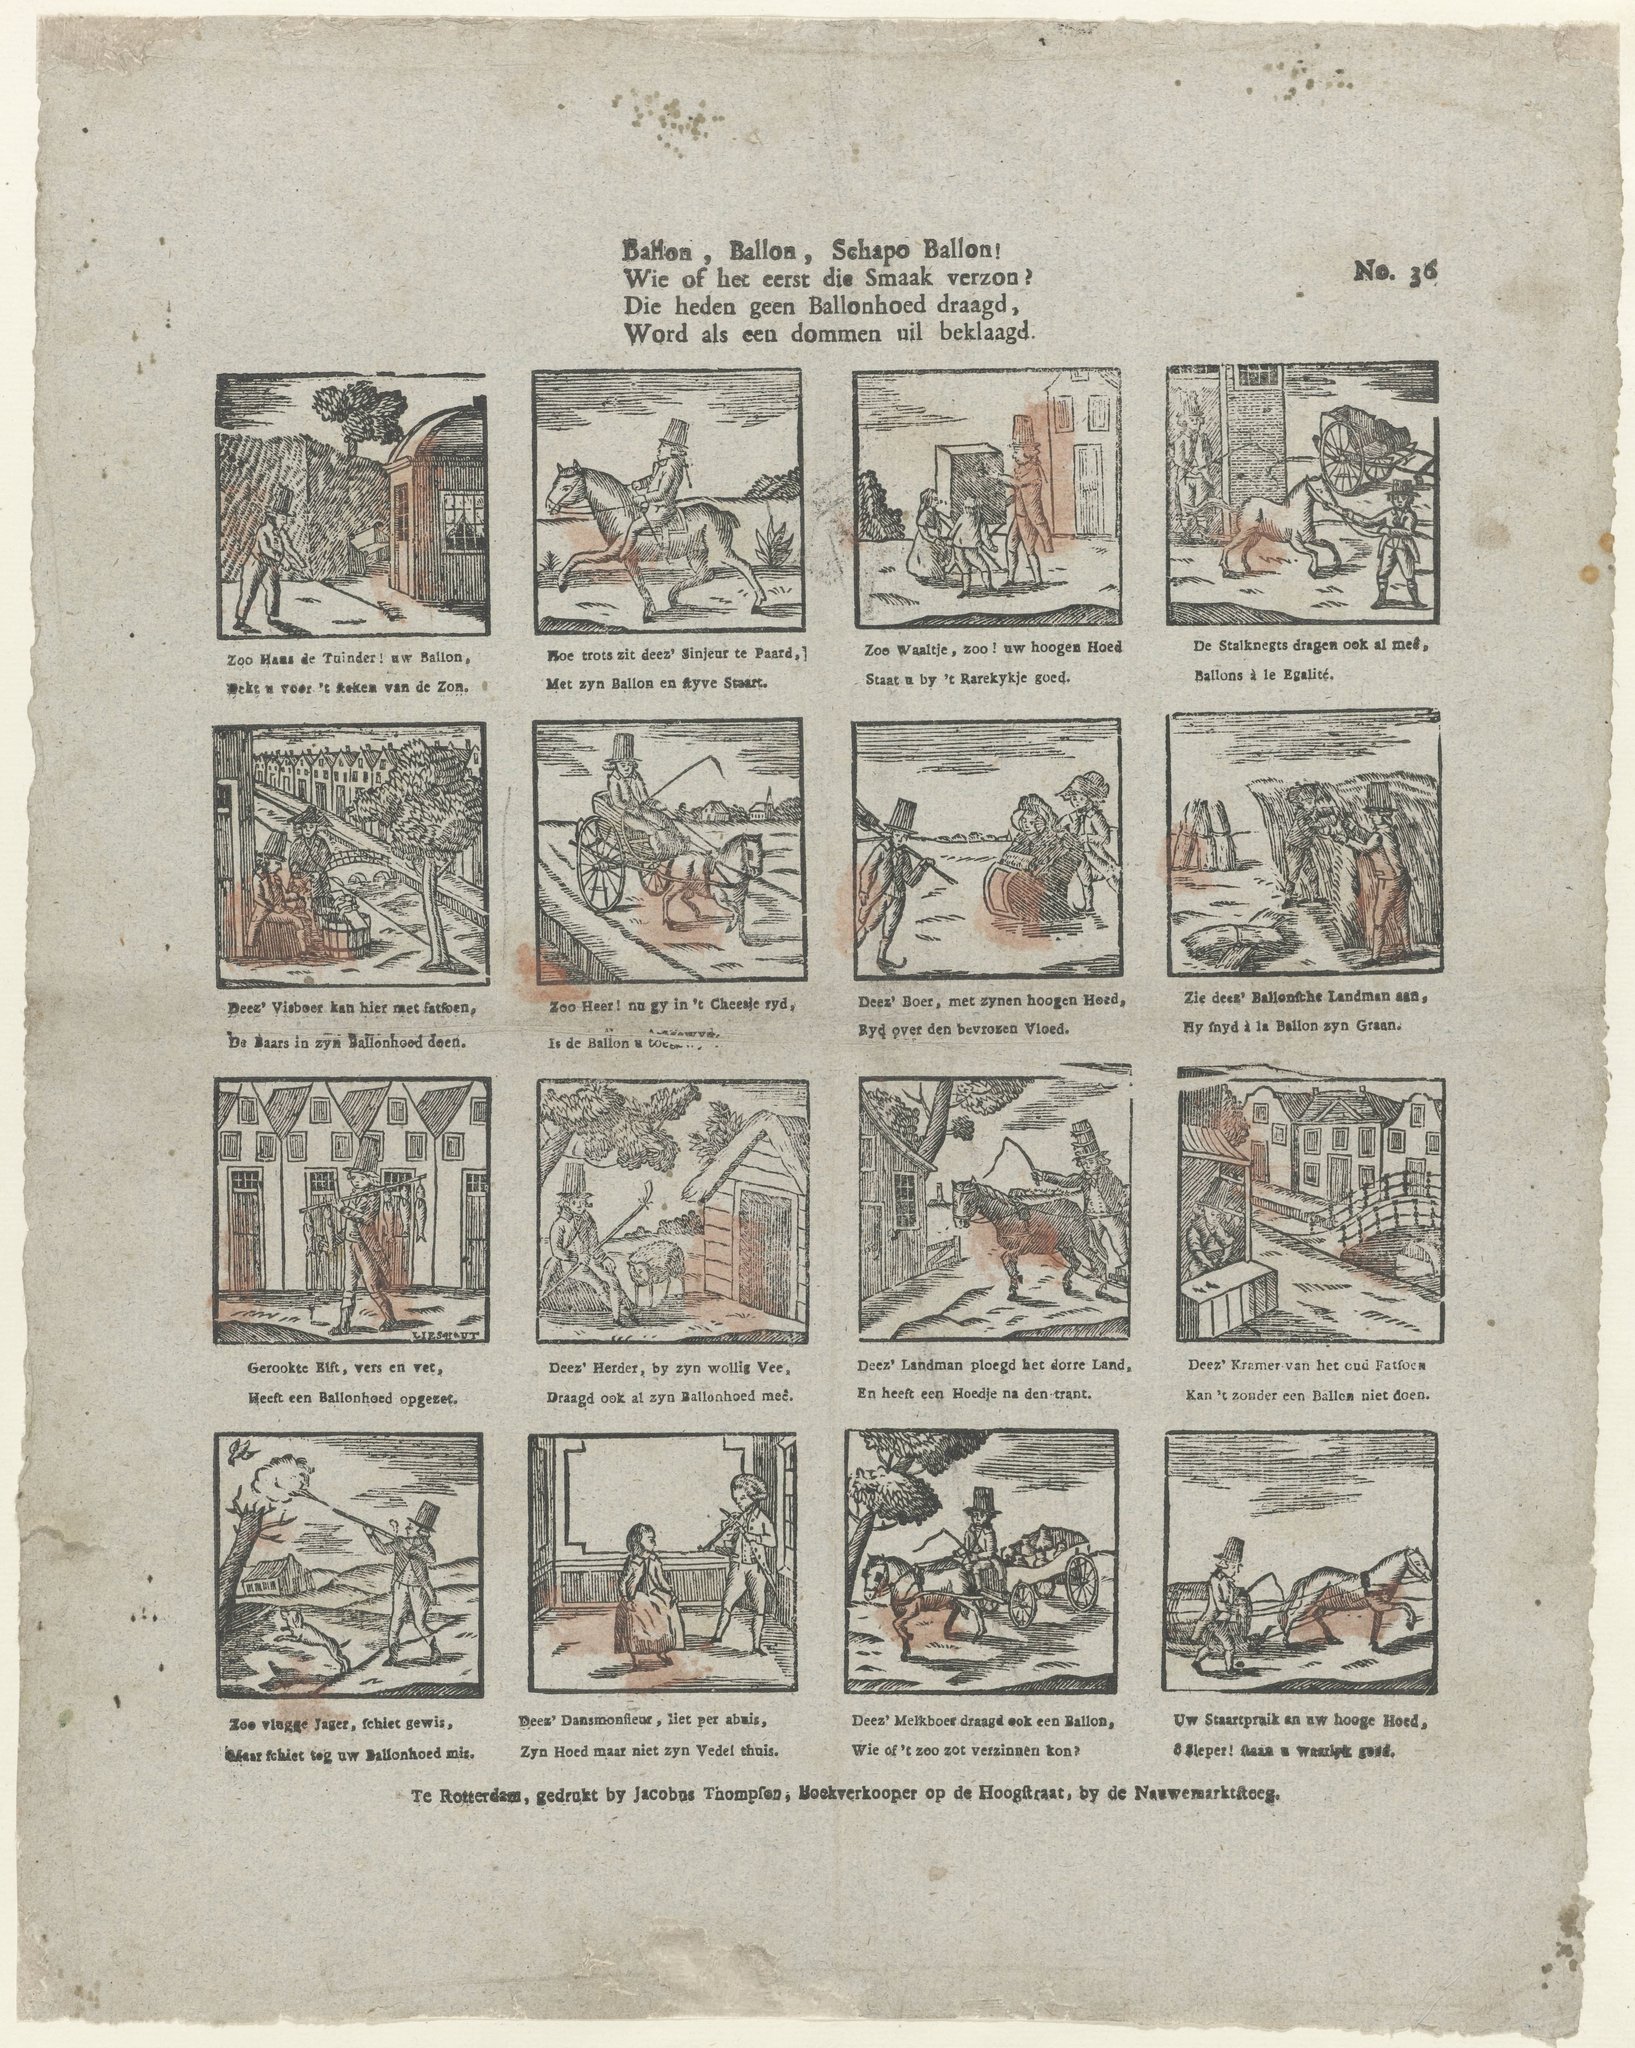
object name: popular print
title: Ballon, ballon, schapo ballon! / Wie of het eerst die smaak verzon? / Die heden geen ballonhoed draagd, / Word als een dommen uit beklaagd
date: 1791-1812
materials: paper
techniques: colour, letterpress printing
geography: netherlands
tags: fashion, clothing, head-gear: top hat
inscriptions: collector's mark: Lugt 2760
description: Spotprent op de mode met 16 voorstellingen over het dragen van een hoge hoed bij verschillende beroepen en activiteiten. Onder elke afbeelding een tweeregelig vers. Genummerd rechtsboven: No. 36.